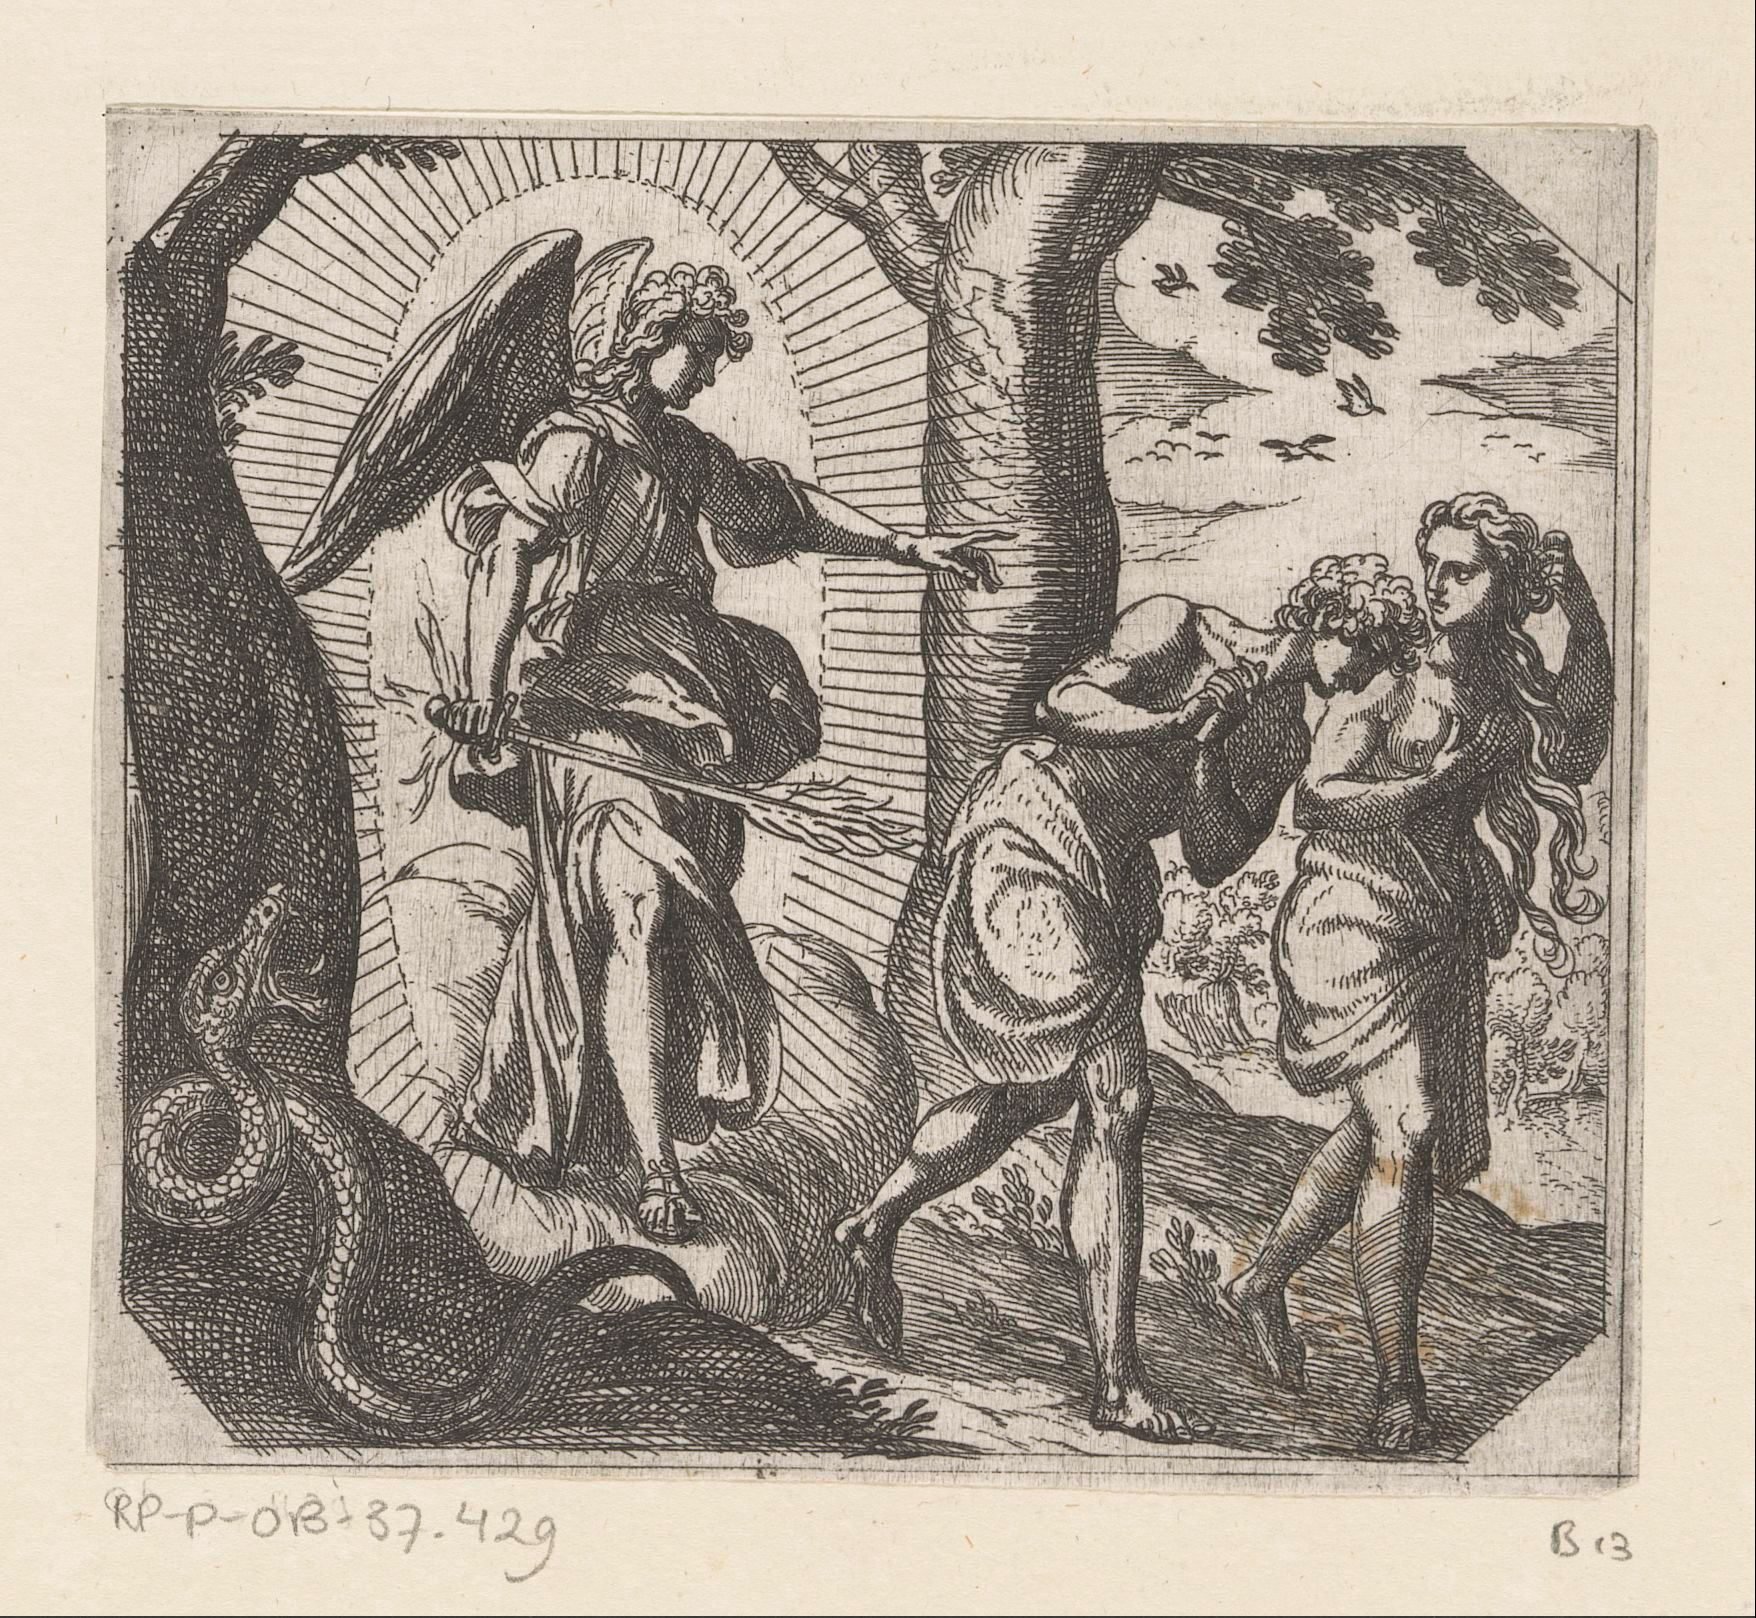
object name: print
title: Expulsion from Paradise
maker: antonio tempesta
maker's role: draughtsman, painter, print maker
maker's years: 1555-1630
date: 1565-1630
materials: paper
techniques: etching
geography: vatican city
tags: expulsion of adam and eve from paradise (genesis 3:22-24)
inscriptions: collector's mark: Lugt 240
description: Deze prent maakt deel uit van een serie van twaalf prenten van de schepping. De prenten zijn deels naar ontwerpen van Rafaël voor de Loggia van Rafaël in het Vaticaan, en deels naar prenten door Nicolaes de Bruyn naar ontwerpen van Maerten de Vos (zie: Holl. Dutch. vol. 45 nr. 1-10).